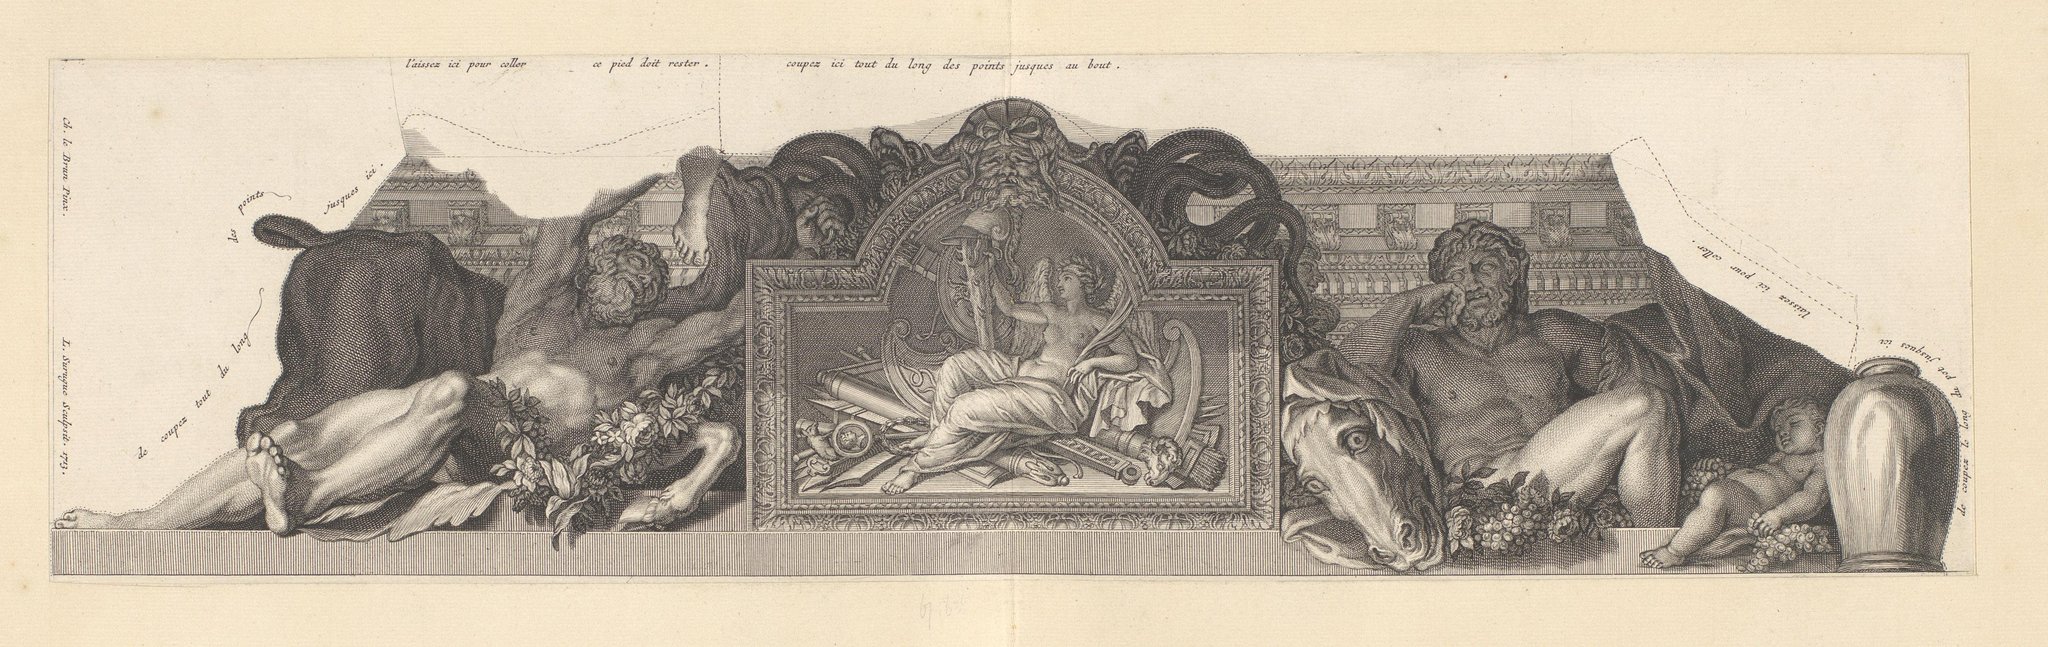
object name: print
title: L'ouvrage de Charles le Brun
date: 1713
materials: paper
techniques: engraving, etching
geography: amsterdam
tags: (decorated) ceiling, (8) the four mares of king diomedes are captured; when diomedes is slain in the ensuing battle his body is thrown to the mares to eat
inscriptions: date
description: Reliëf met Victoria, gezeten op een berg wapens, met de knots van Hercules en een palmtak in de handen. Het reliëf wordt geflankeerd door Hercules, die de stier van Kreta vangt, en rechts door Hercules met een door hem gevangen paard van Diomedes. Langs de randen instructies voor het monteren van de prent aan andere prenten. Prent maakt deel uit van een serie prenten, die samen het geschilderde plafond met de Apotheose van Hercules in het Hôtel Lambert te Parijs voorstellen. Deze prent maakt deel uit van een album.